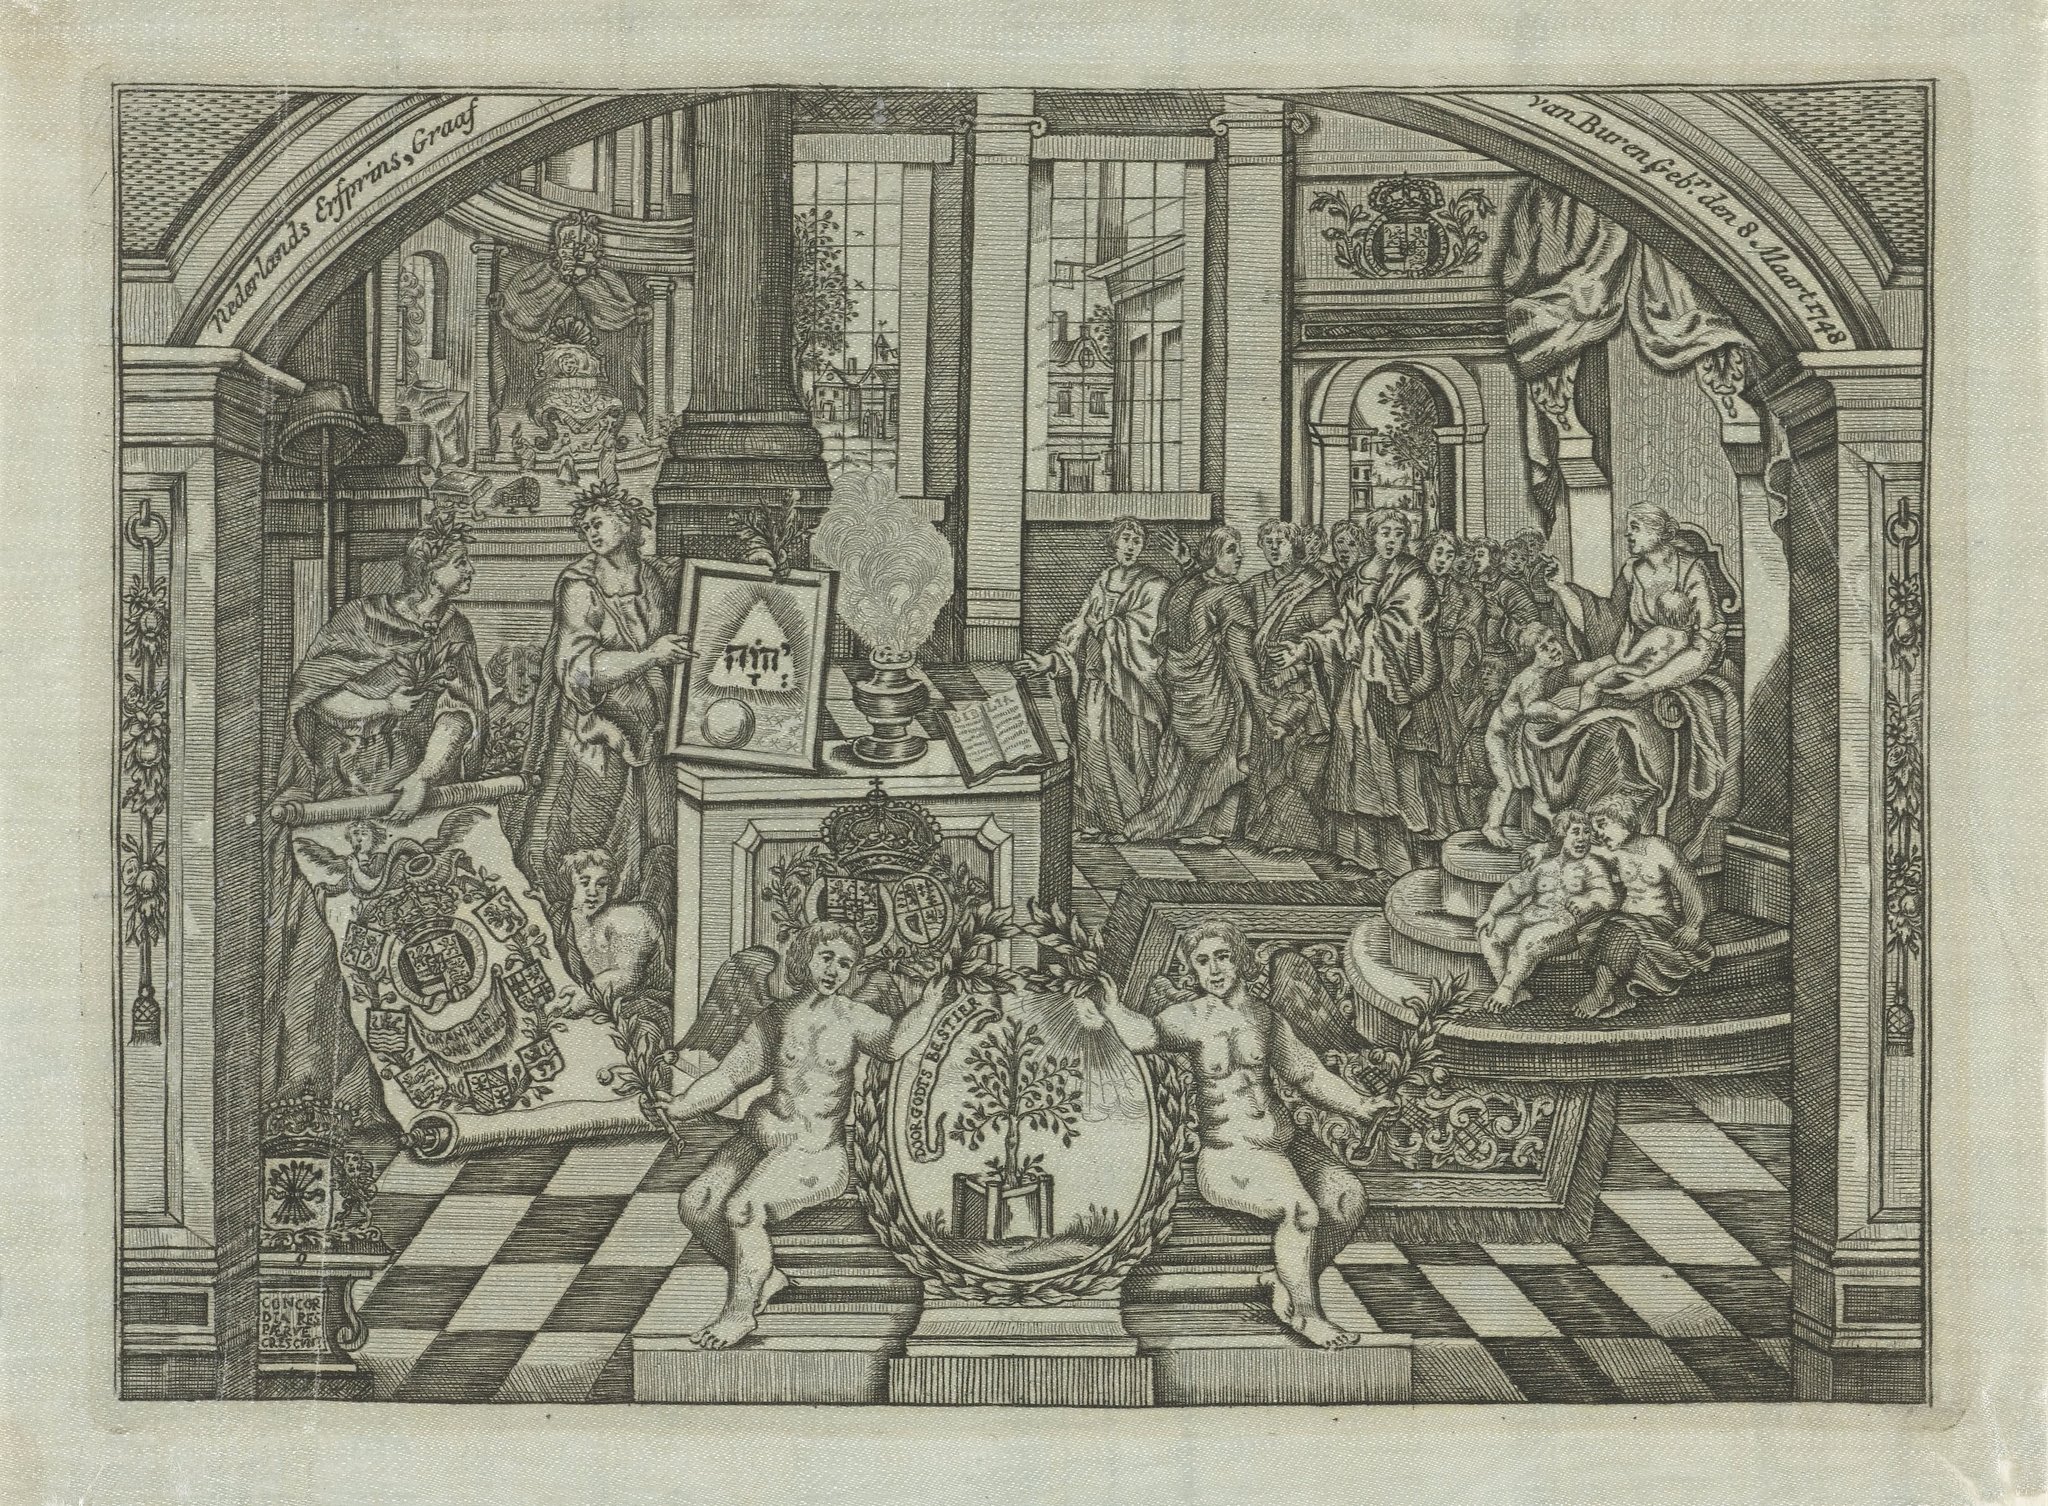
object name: print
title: Allegorie op de geboorte van de prins van Oranje, 1748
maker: gerrit sibersma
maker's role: print maker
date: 1748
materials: textile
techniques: engraving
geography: northern netherlands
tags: william v (prince of orange), charity, 'caritas'; 'carità' (ripa) ~ one of the three theological virtues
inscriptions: collector's mark: Lugt 2228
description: Allegorie op de geboorte van Willem V, de graaf van Buren, prins van Oranje, 8 maart 1748. Interieur met links de Vrijheid en de Wijsheid, rechts de Liefde op de troon, centraal twee putti met een embleem met de Oranjeboom.